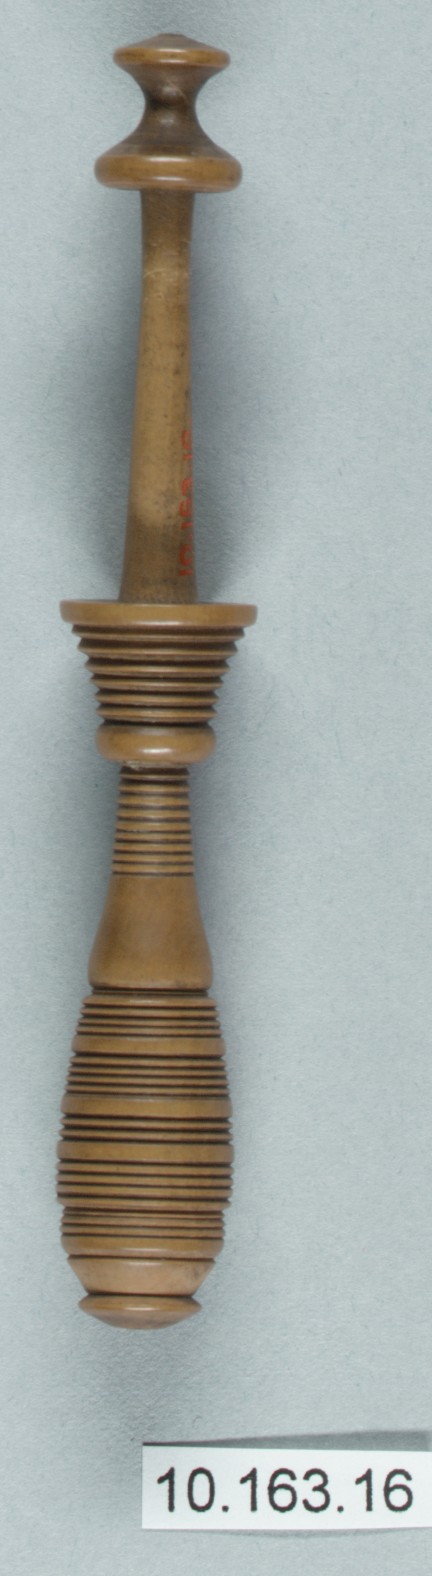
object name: bobbin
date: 1801-1900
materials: wood